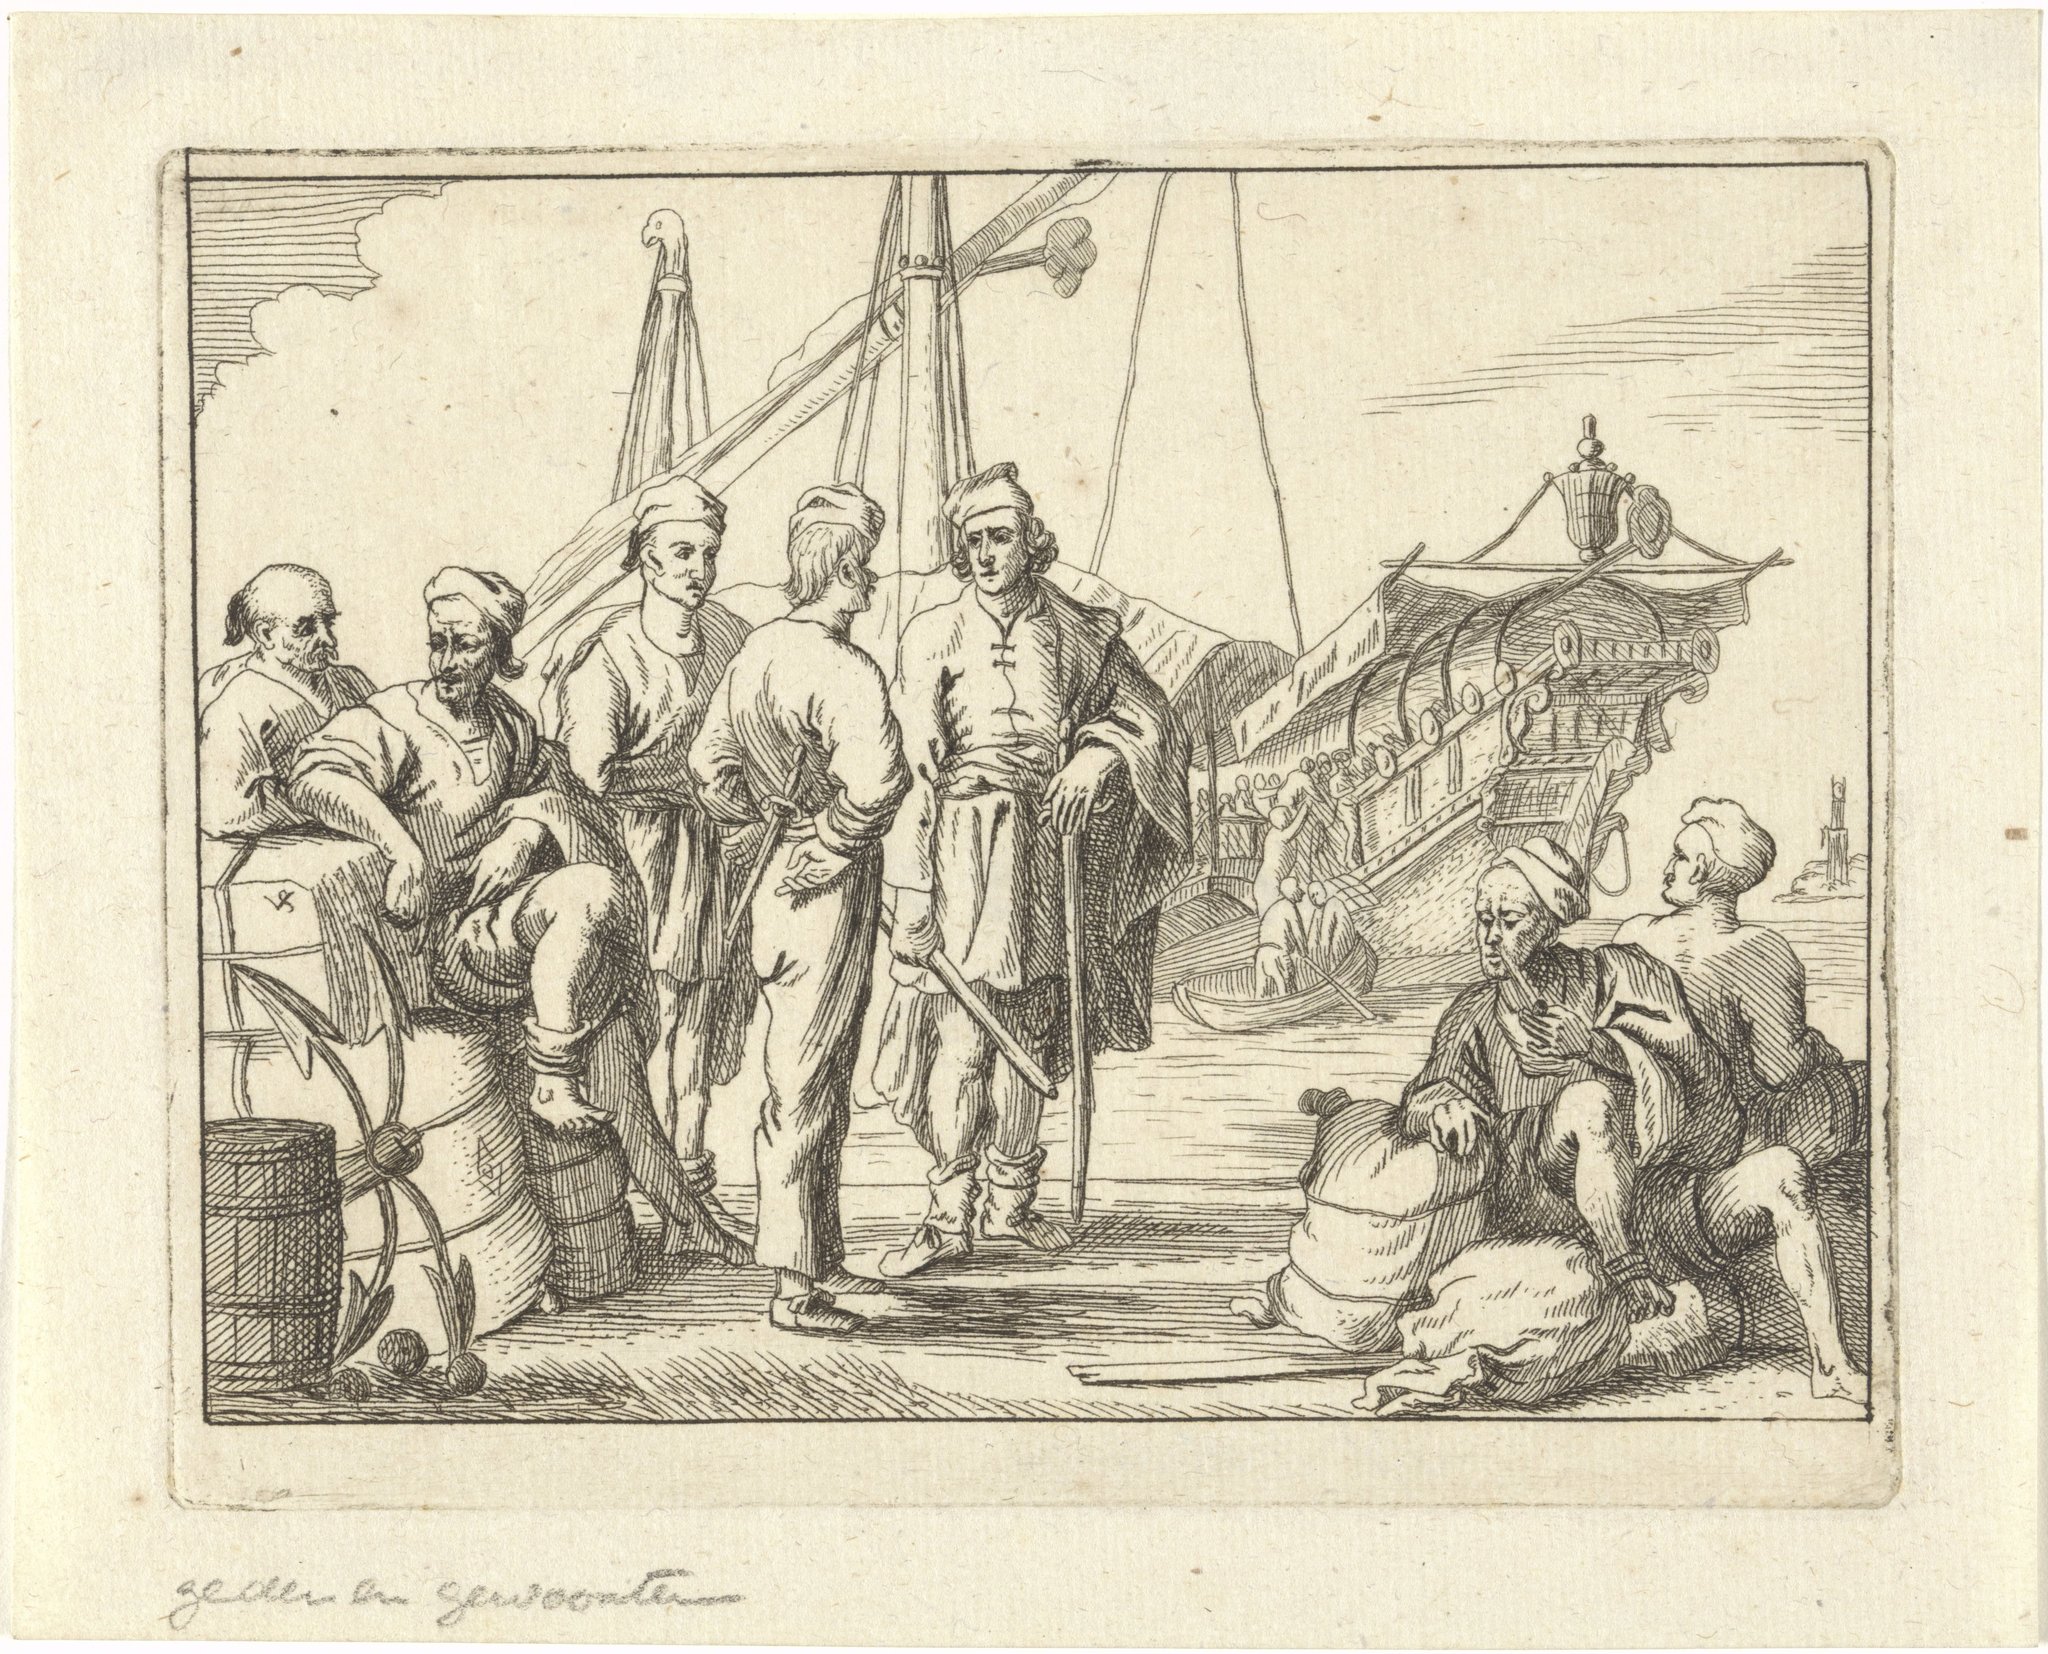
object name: print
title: Zeelieden voor een galei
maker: m. schaep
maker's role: print maker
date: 1649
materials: paper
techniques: etching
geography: northern netherlands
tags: harbour, trireme, galley (+ view ~ vehicle, ship, etc.), slavery; serfs and enslaved persons, seaman: sailor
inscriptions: collector's mark: Lugt 2228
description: Twee zeelieden staan met elkaar te praten. Naast hen staat een islamitische galeislaaf. Om hen heen zitten en leunen andere islamitische galeislaven op balen en zakken. Deze tot slaaf gemaakte mannen zijn als moslims te herkennen door het typerende kapsel (hoofd op een pluk na kaalgeschoren) dat zij verplicht waren te hebben. Links op de voorgrond een ton en een anker. Achter hen wordt een galei met behulp van een roeiboot geladen of gelost.